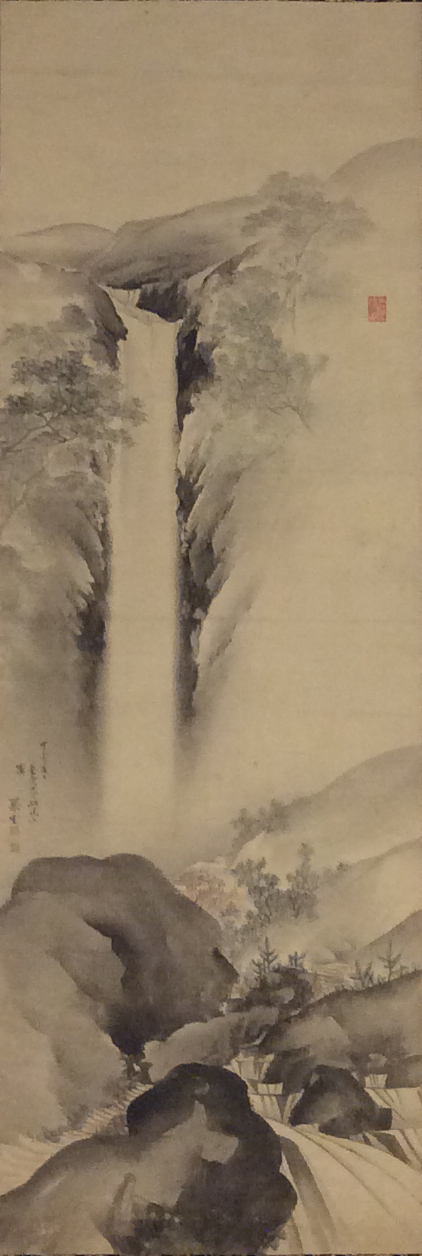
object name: hanging scroll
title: Yōrō Waterfall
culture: japanese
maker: tazaki sōun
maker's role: artist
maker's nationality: japanese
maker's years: 1815-1898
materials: ink, silk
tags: waterfalls